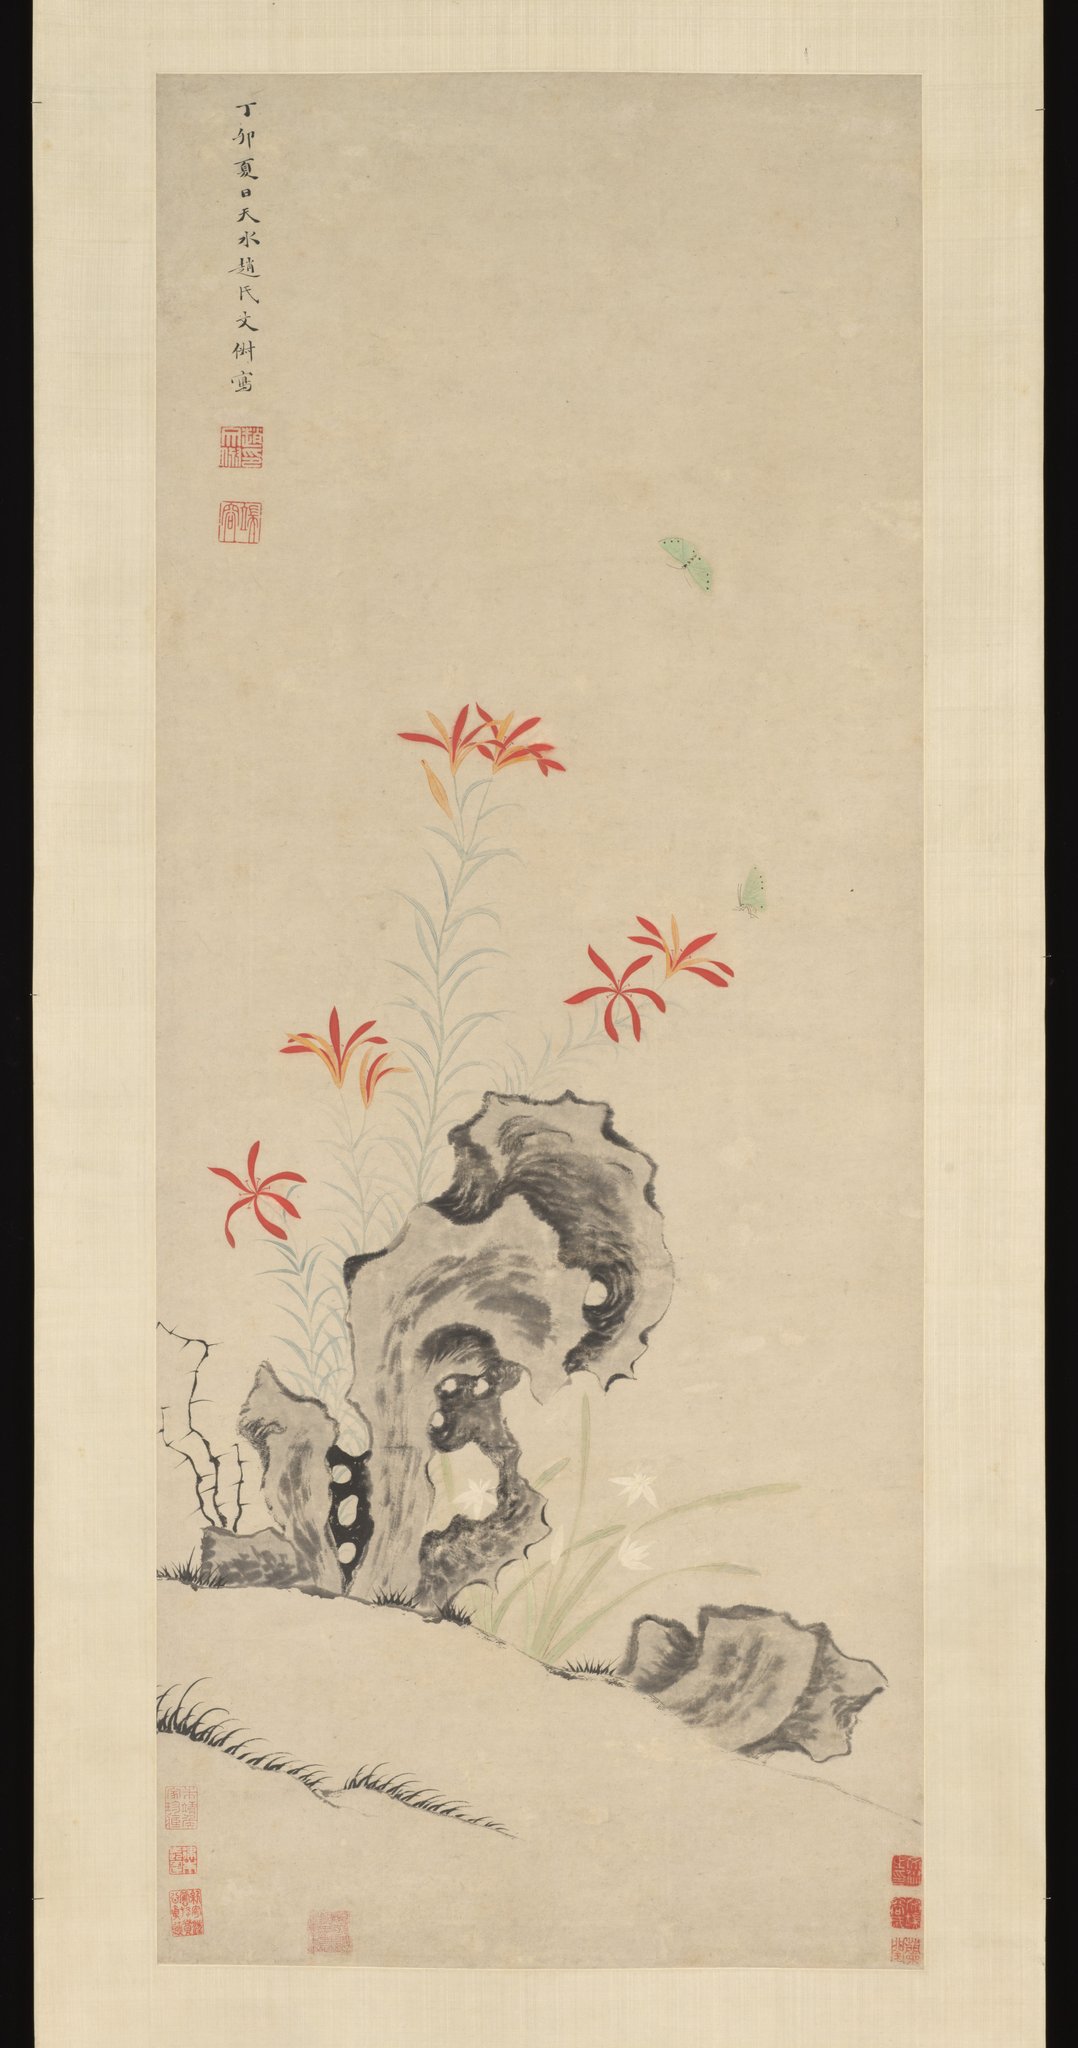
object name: hanging scroll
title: Rock, Tiger Lily and Orchid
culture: chinese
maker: unidentified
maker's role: artist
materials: ink, paper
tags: flowers,orchids